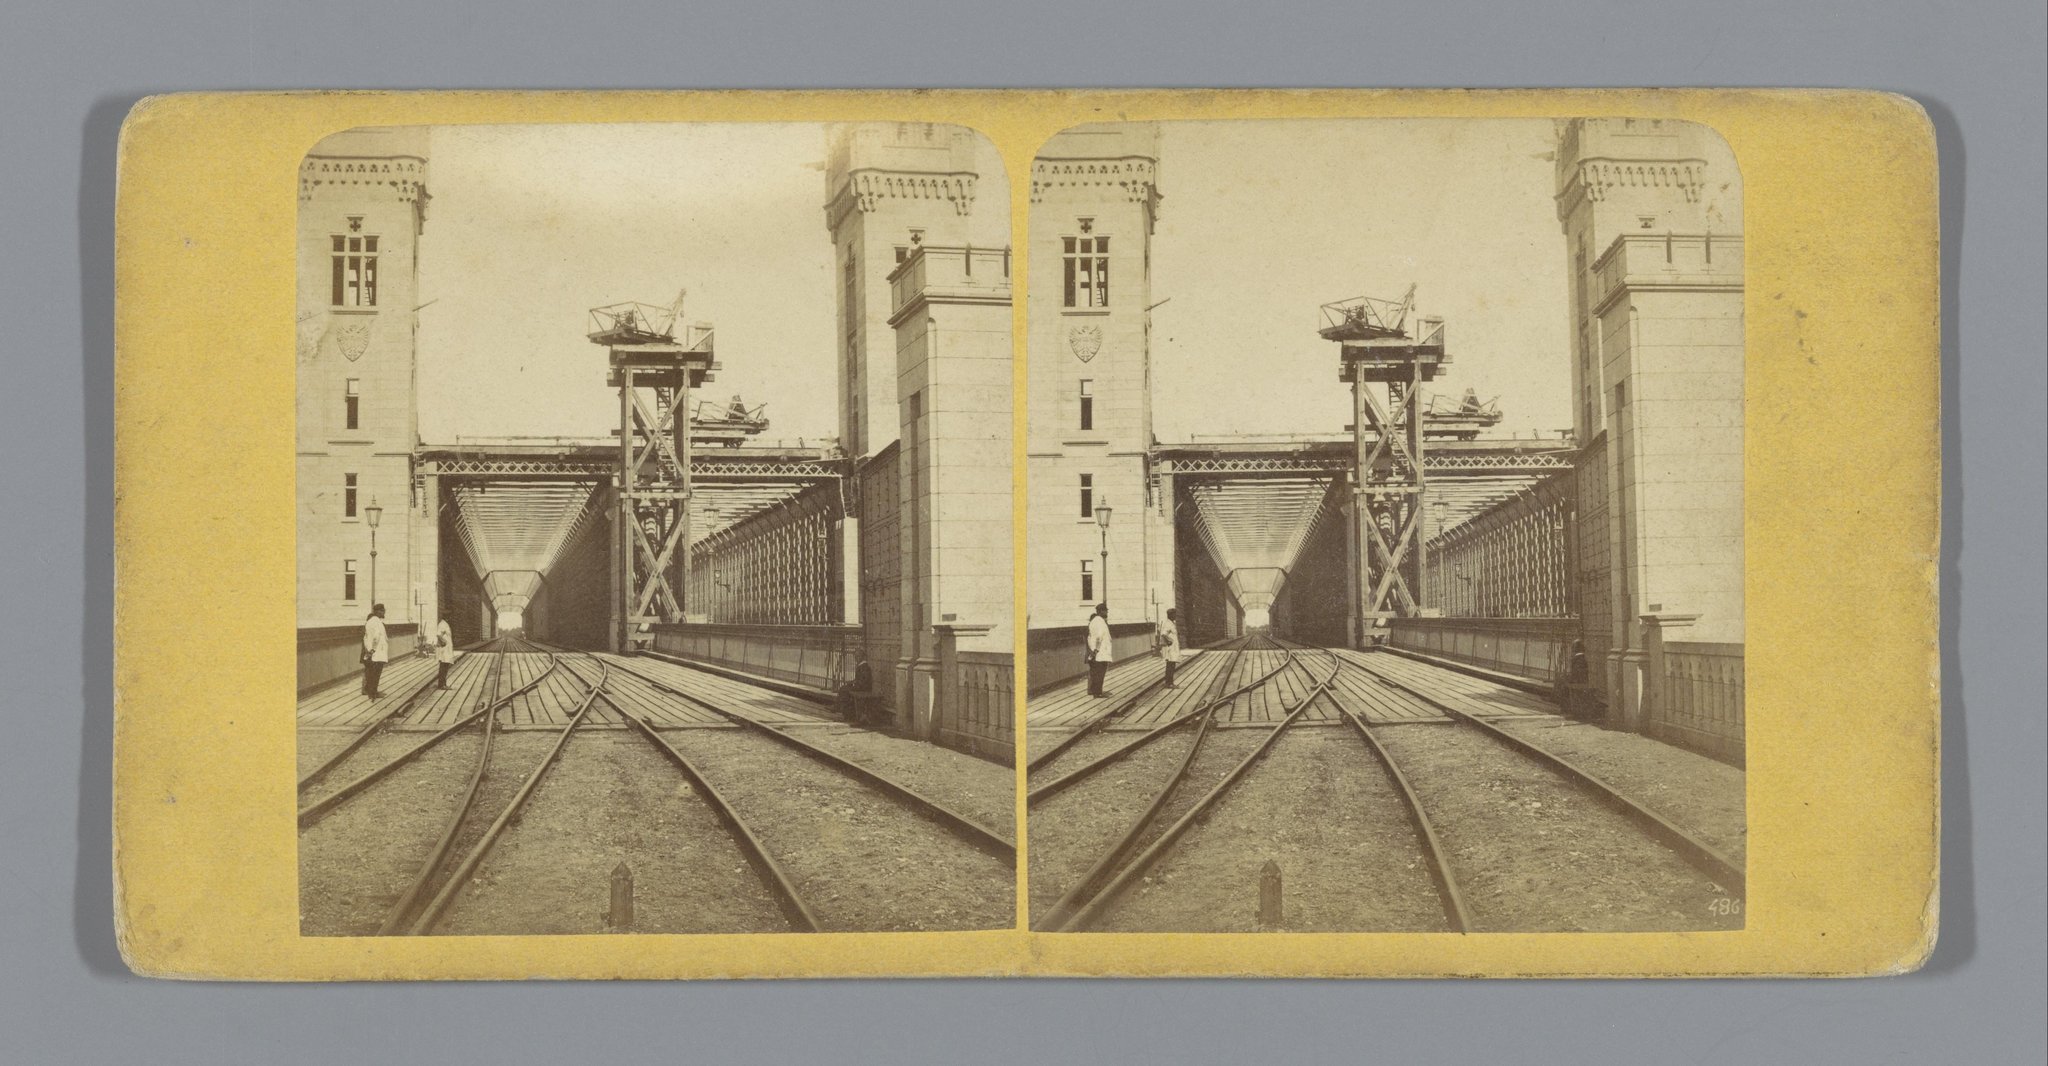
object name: stereograph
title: Gezicht op de Dombrücke te Keulen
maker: Anonymous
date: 1860-1880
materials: cardboard, photographic support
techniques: albumen print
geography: cologne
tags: bridge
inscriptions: number: ‘486’